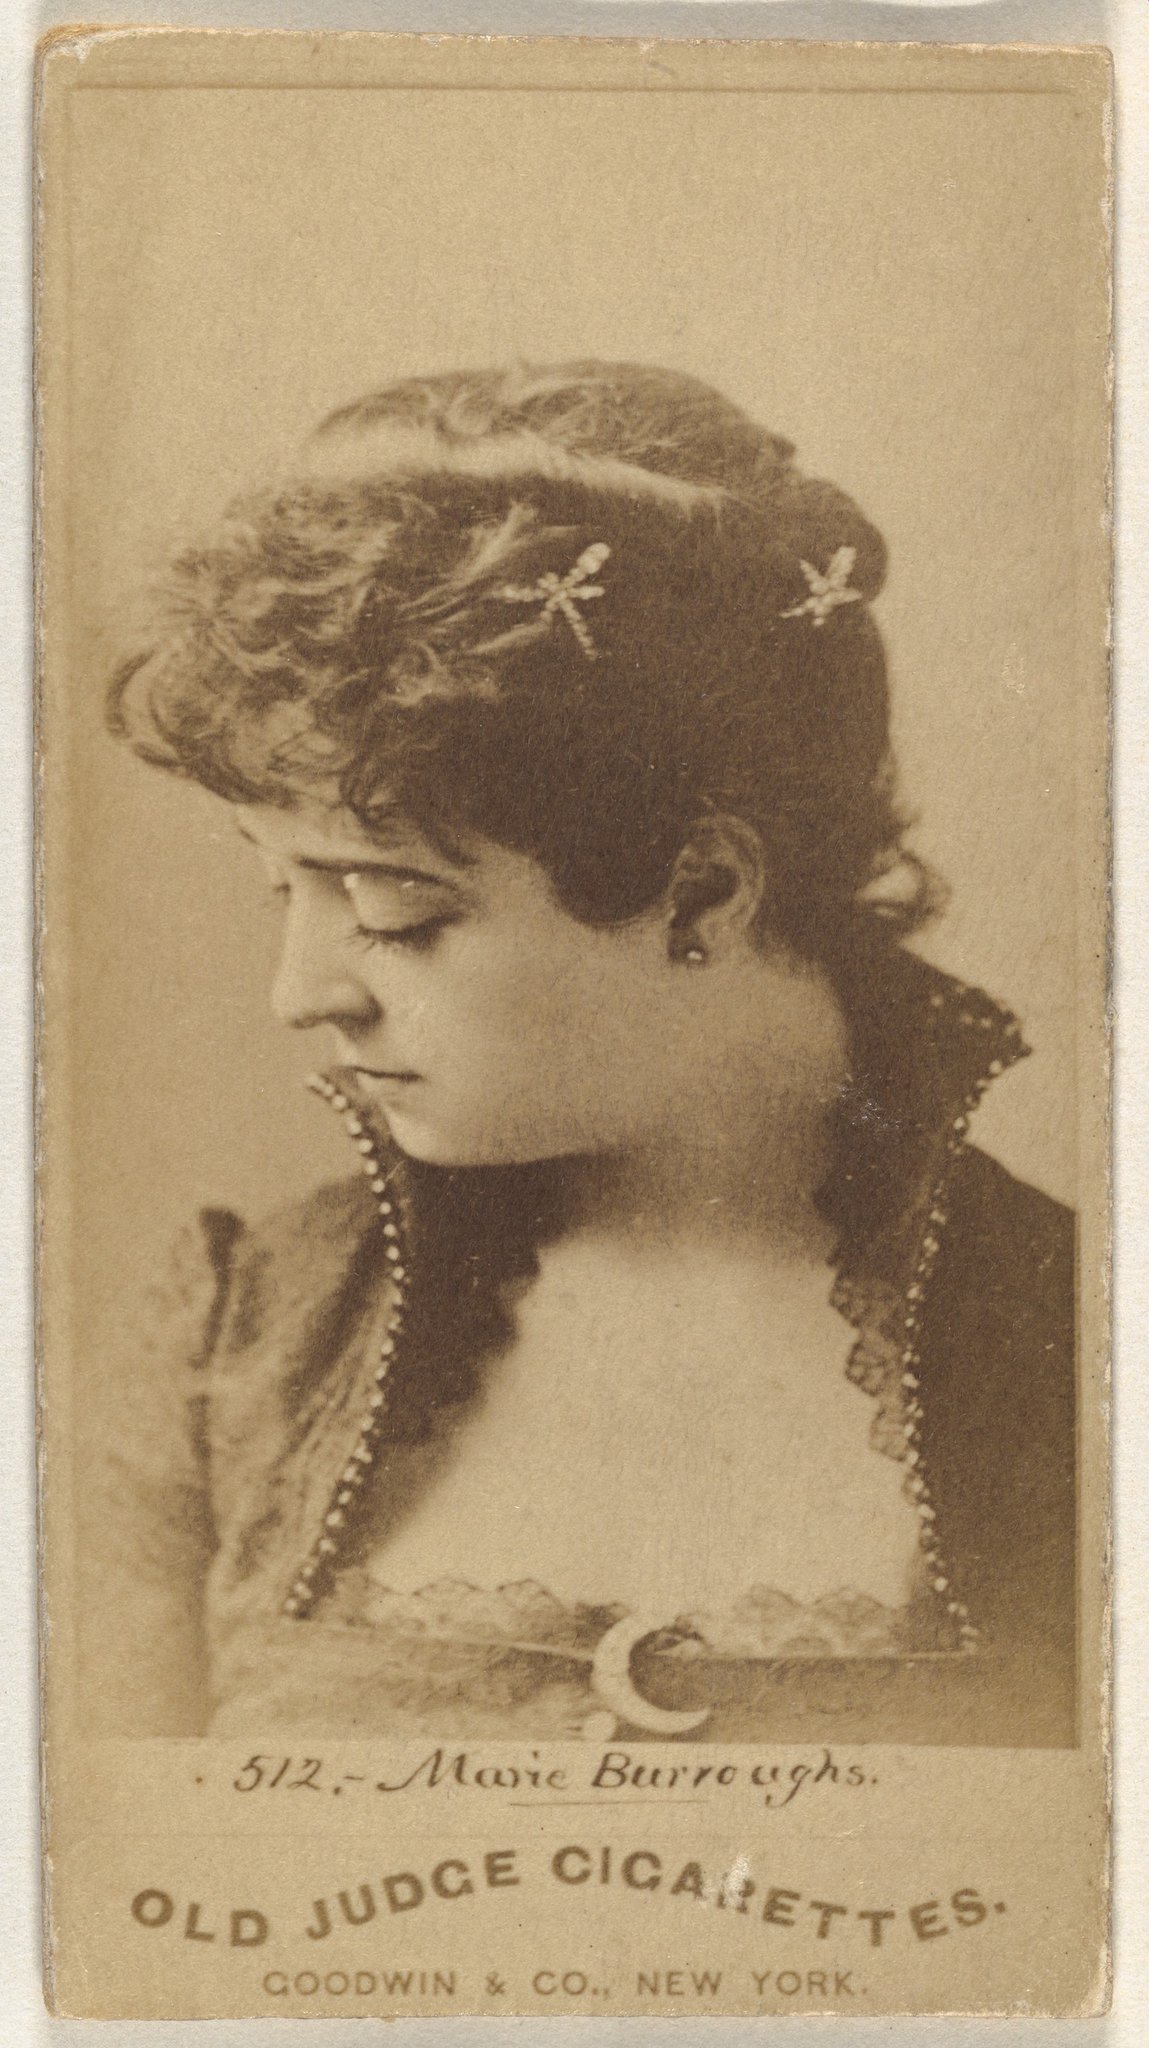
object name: photograph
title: Marie Burroughs, from the Actors and Actresses series (N171) for Old Judge Cigarettes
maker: goodwin & company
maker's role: publisher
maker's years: 1850-1950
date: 1886-1890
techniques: albumen silver print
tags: portraits,women,actresses